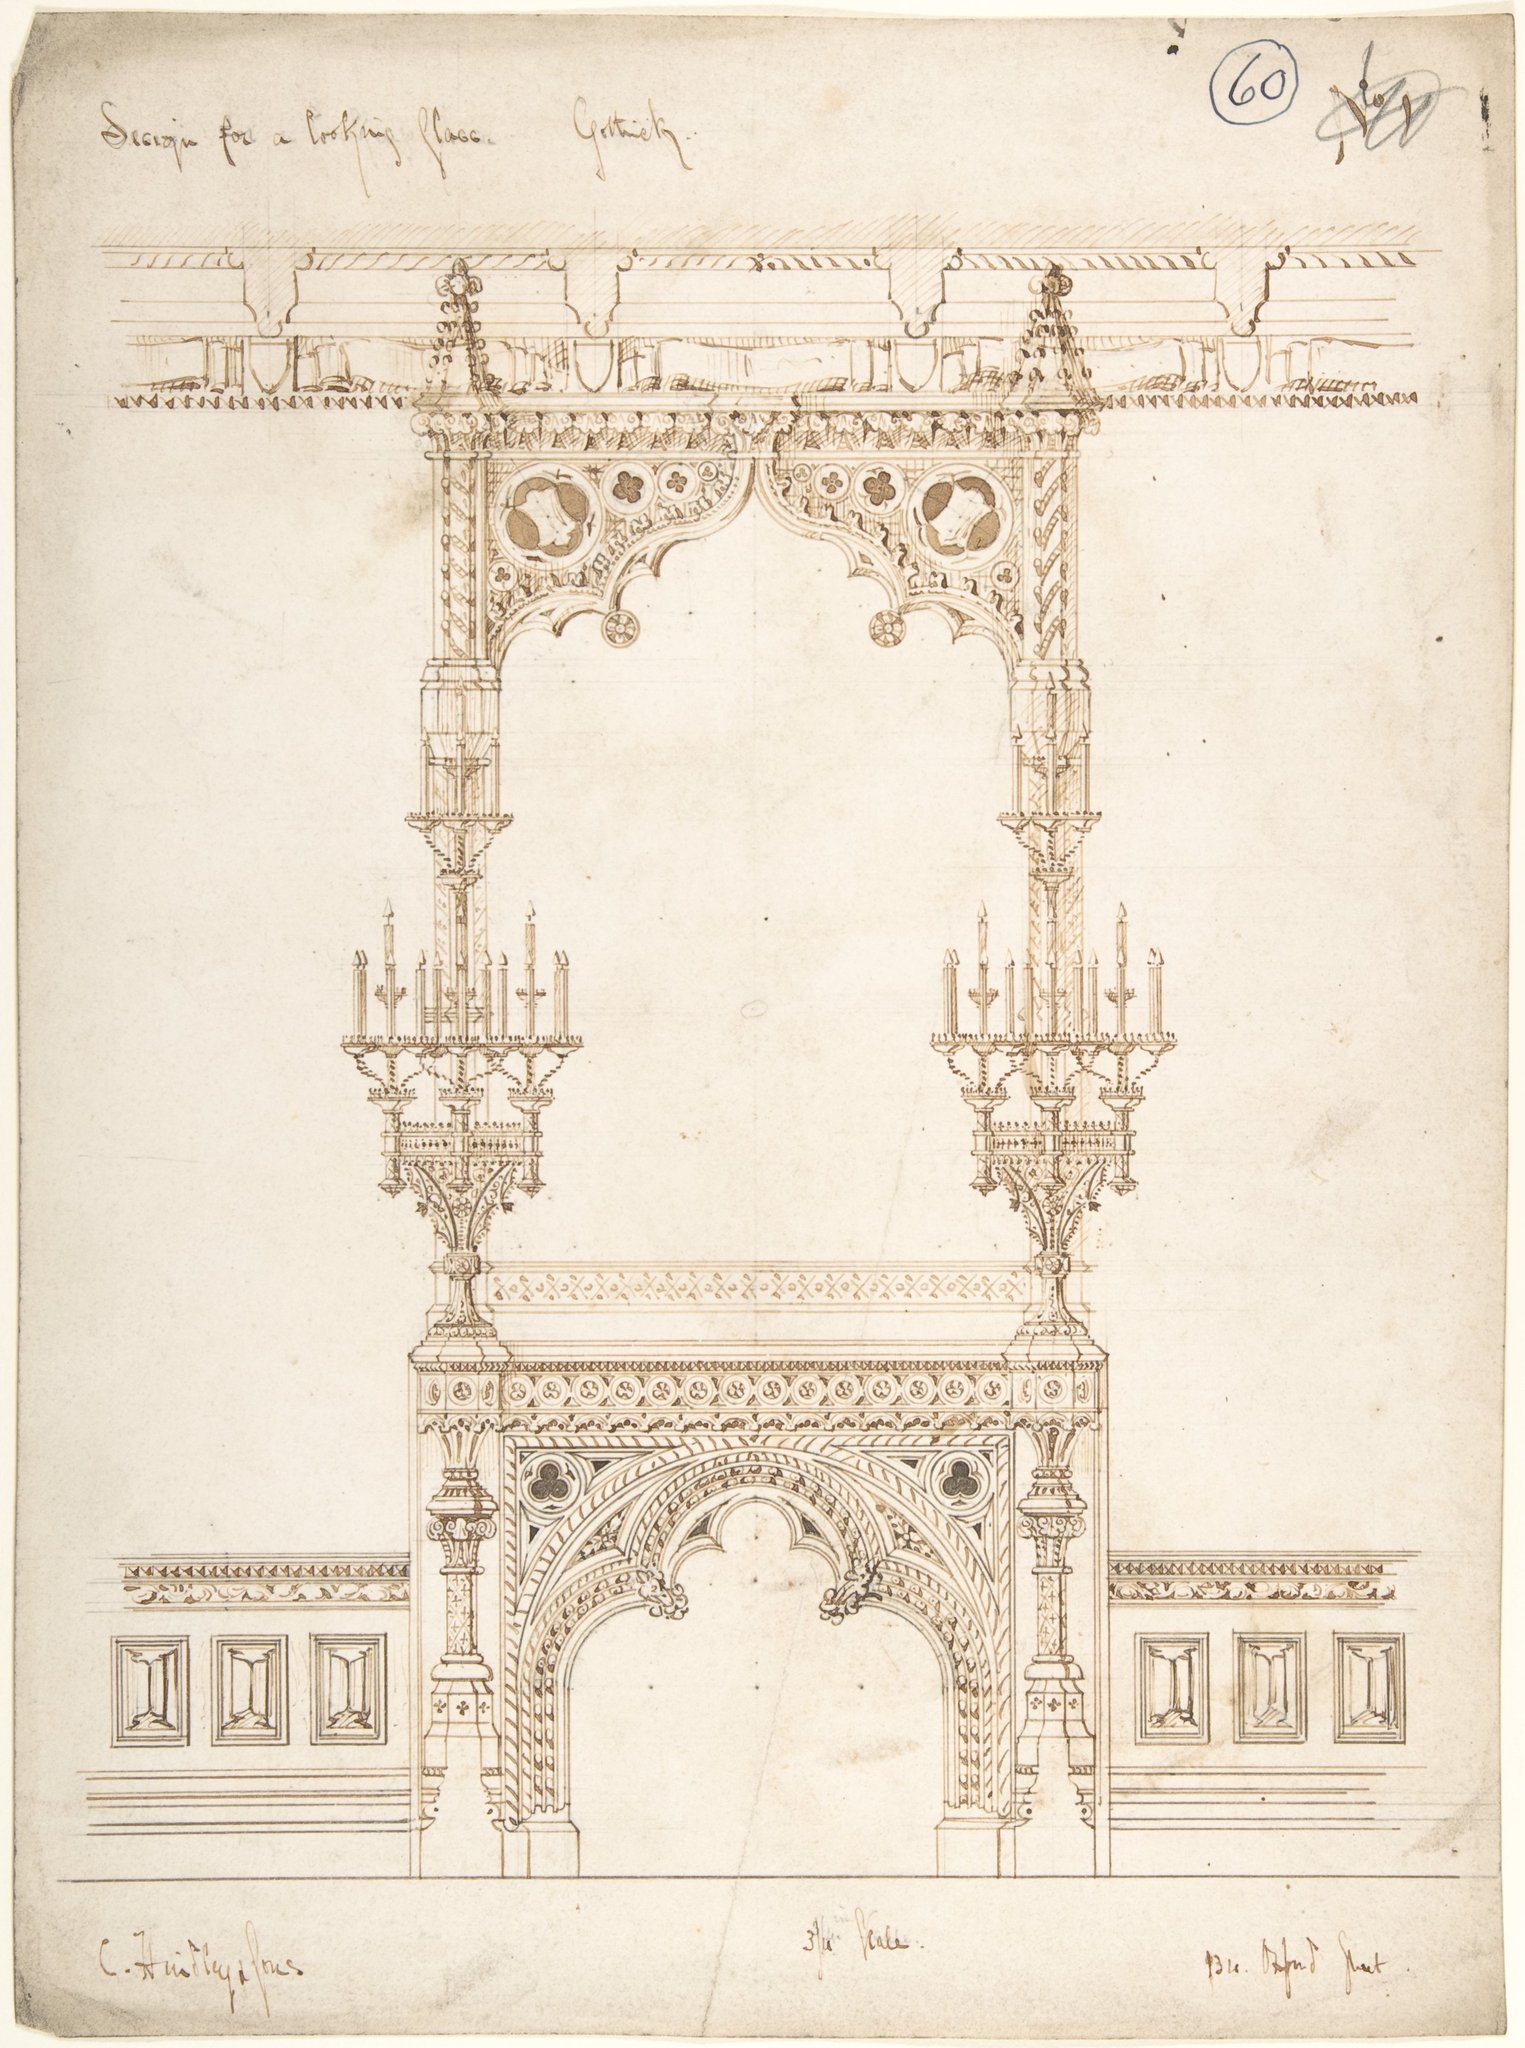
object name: drawing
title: Design for a Gothic Mirror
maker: charles hindley and sons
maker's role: artist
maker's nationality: british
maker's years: 1841-1917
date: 1841-1884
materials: ink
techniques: pen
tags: mirrors